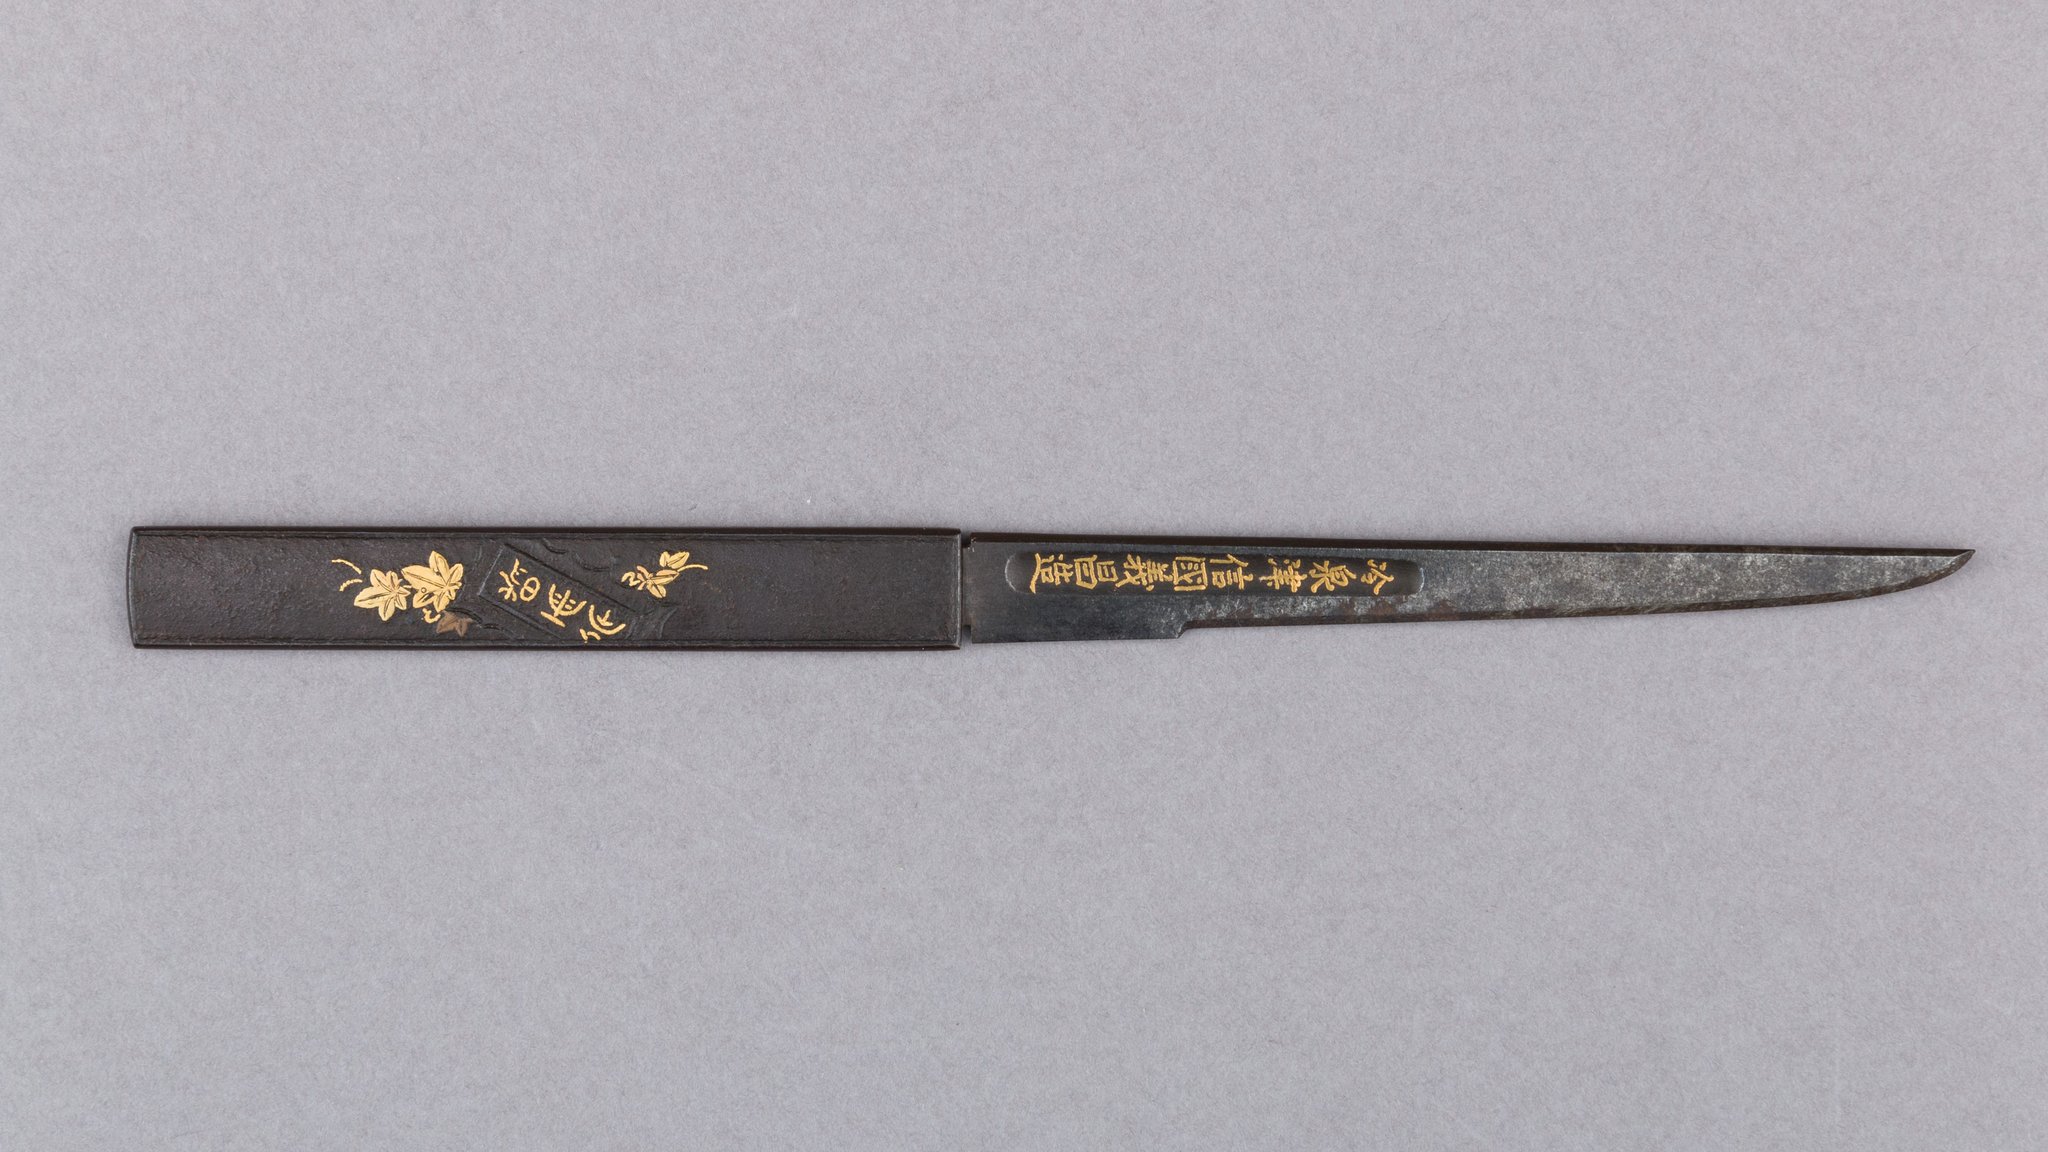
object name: knife handle kozuka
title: Knife Handle (Kozuka) with Blade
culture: japanese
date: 1701-1800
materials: copper, gold alloy, gold, steel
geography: japan